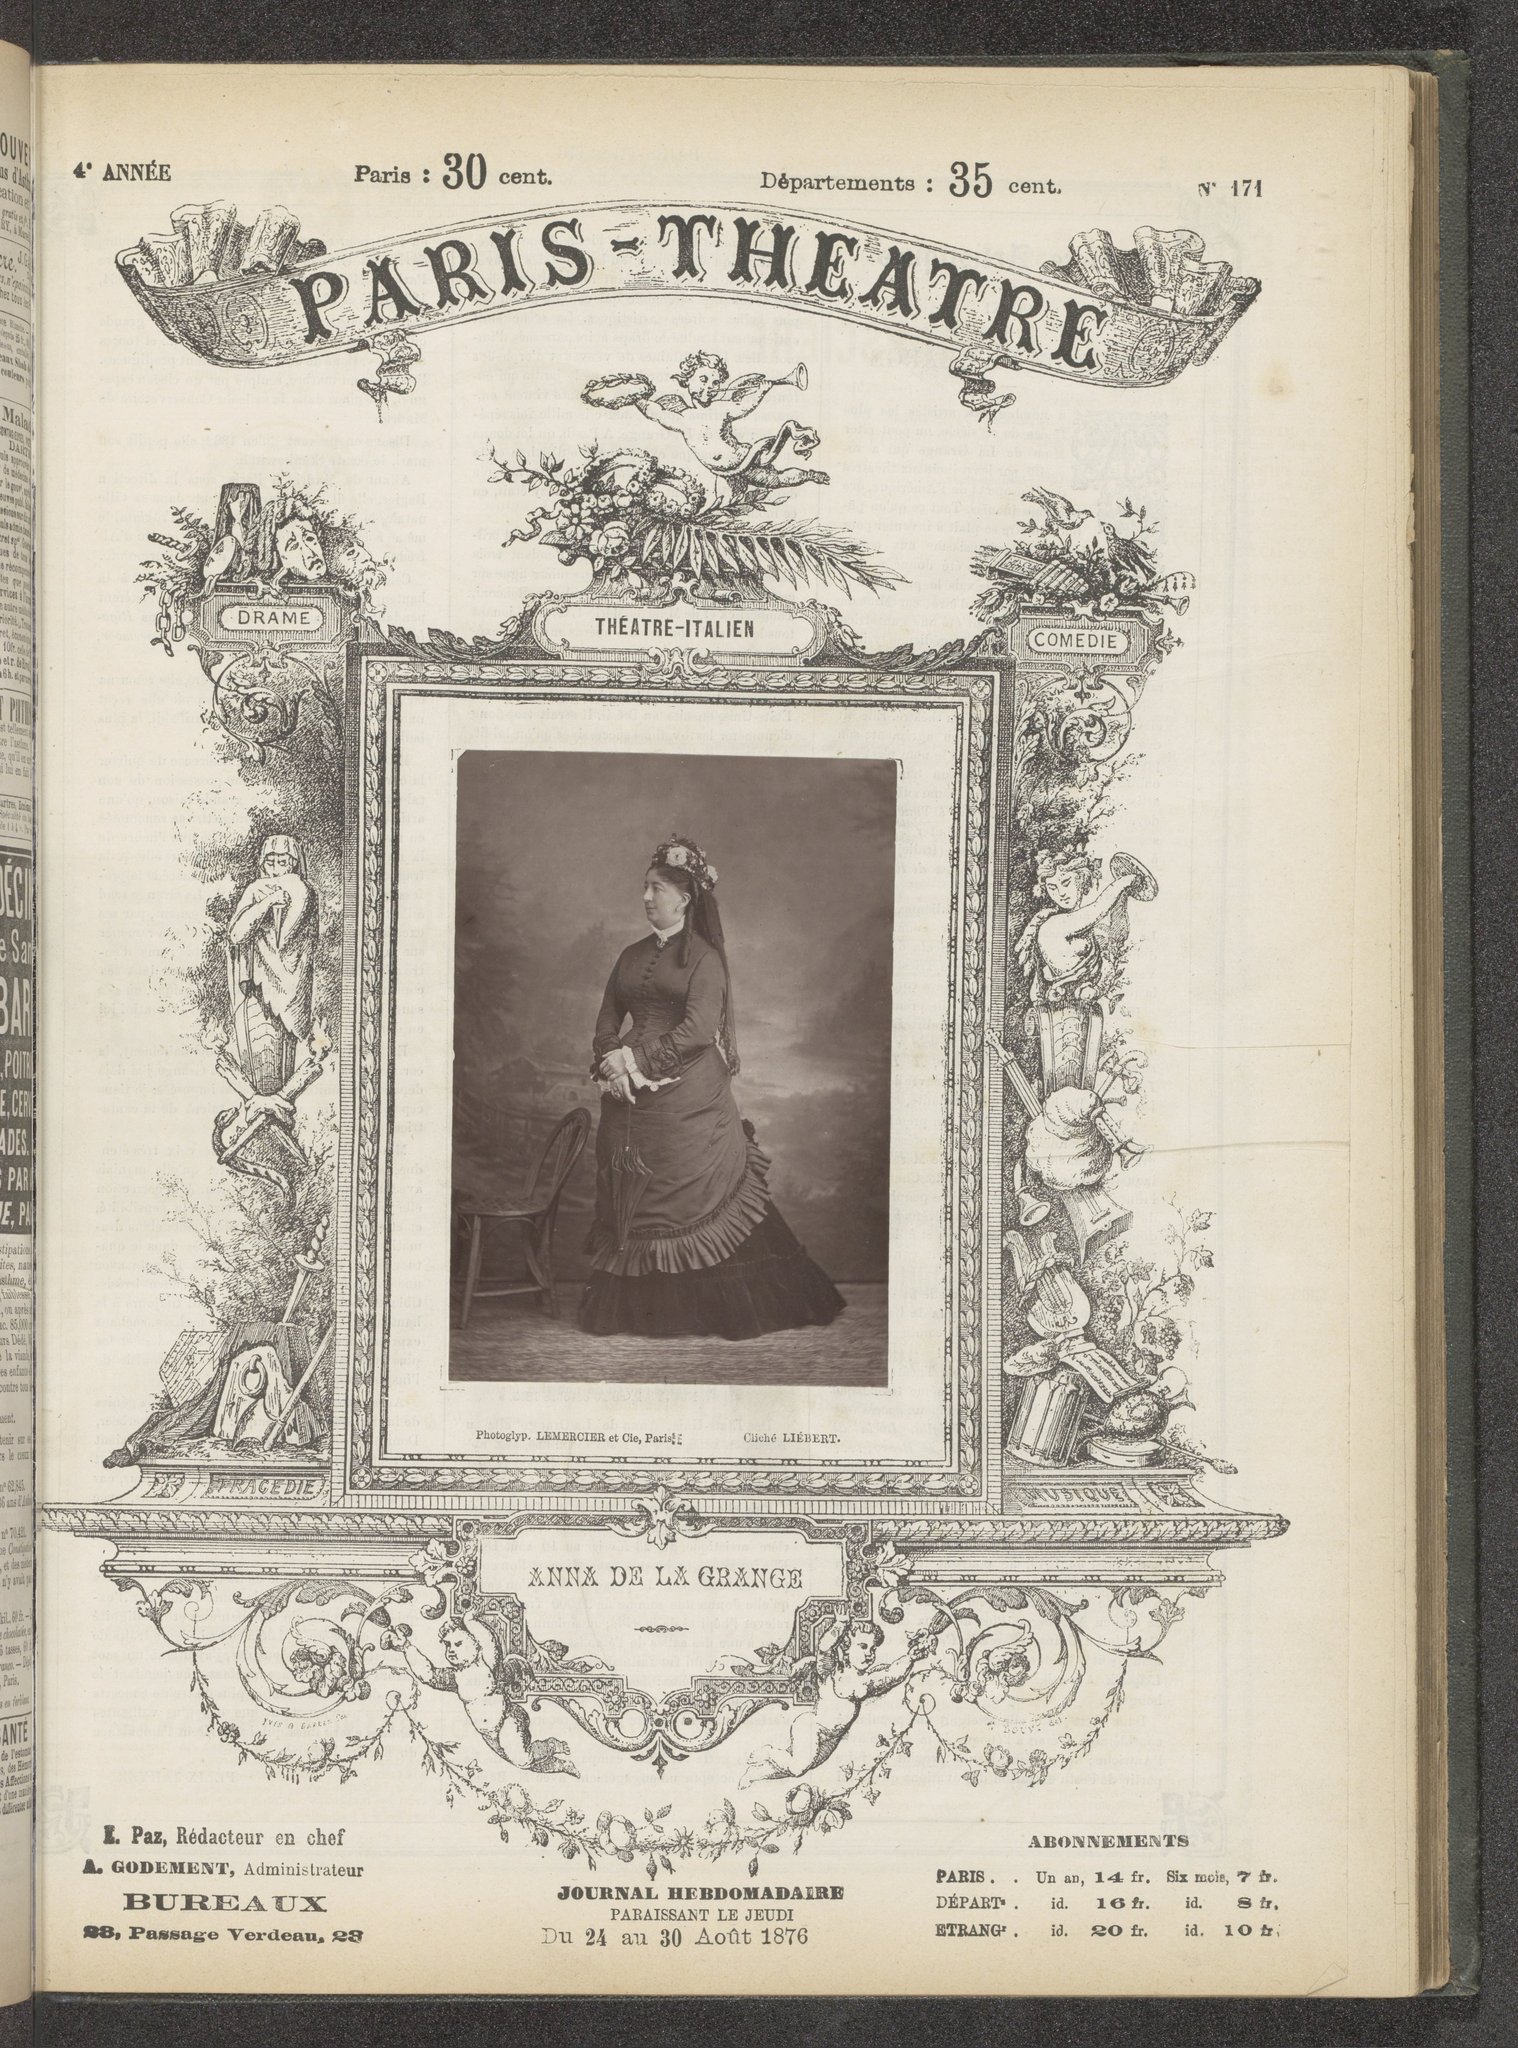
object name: photomechanical print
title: Anna de La Grange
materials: paper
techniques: woodburytype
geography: france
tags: portrait of opera-singer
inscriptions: inscription: ‘Journal hebdomadaire paraissant le jeudi Du 24 au 30 Août 1876’, number: ‘No 171’